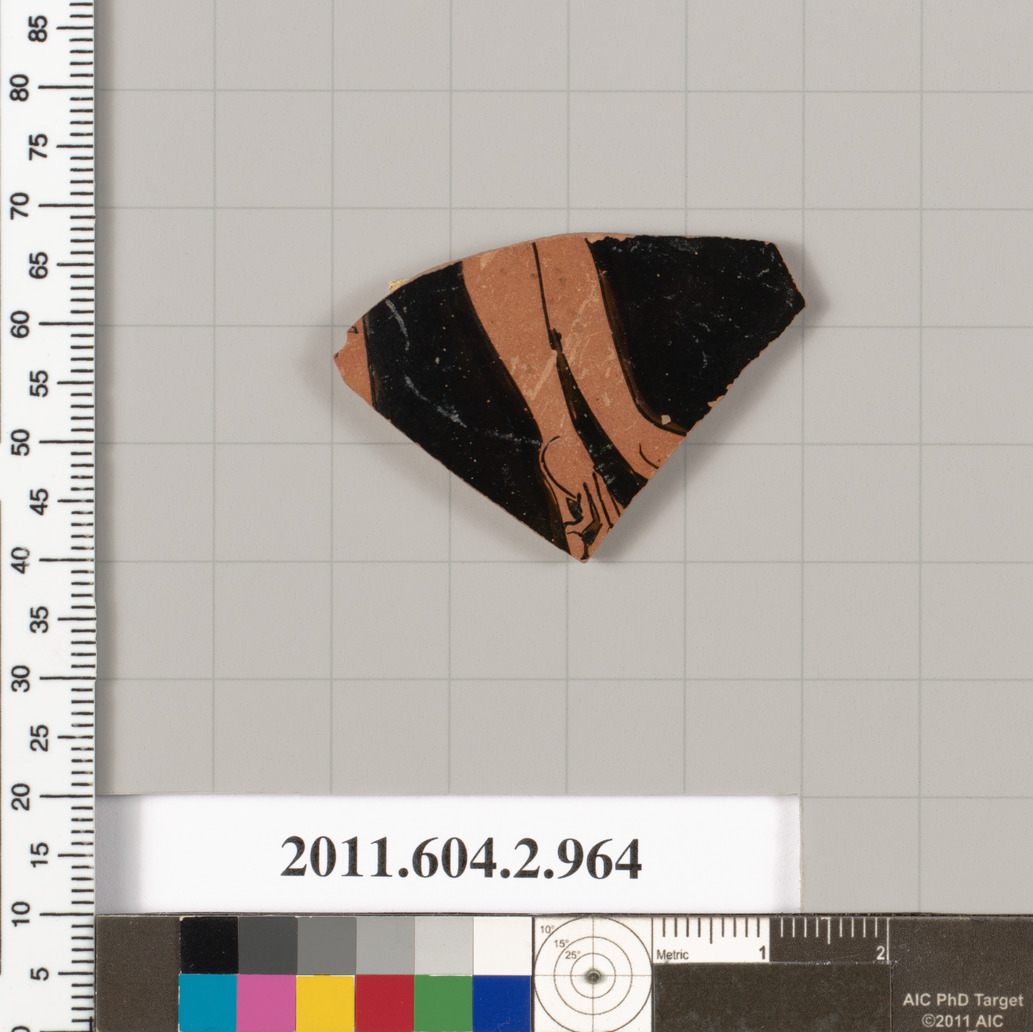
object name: oinochoe fragment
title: Terracotta fragment of an oinochoe (jug)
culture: greek, attic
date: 475-451 BCE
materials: terracotta